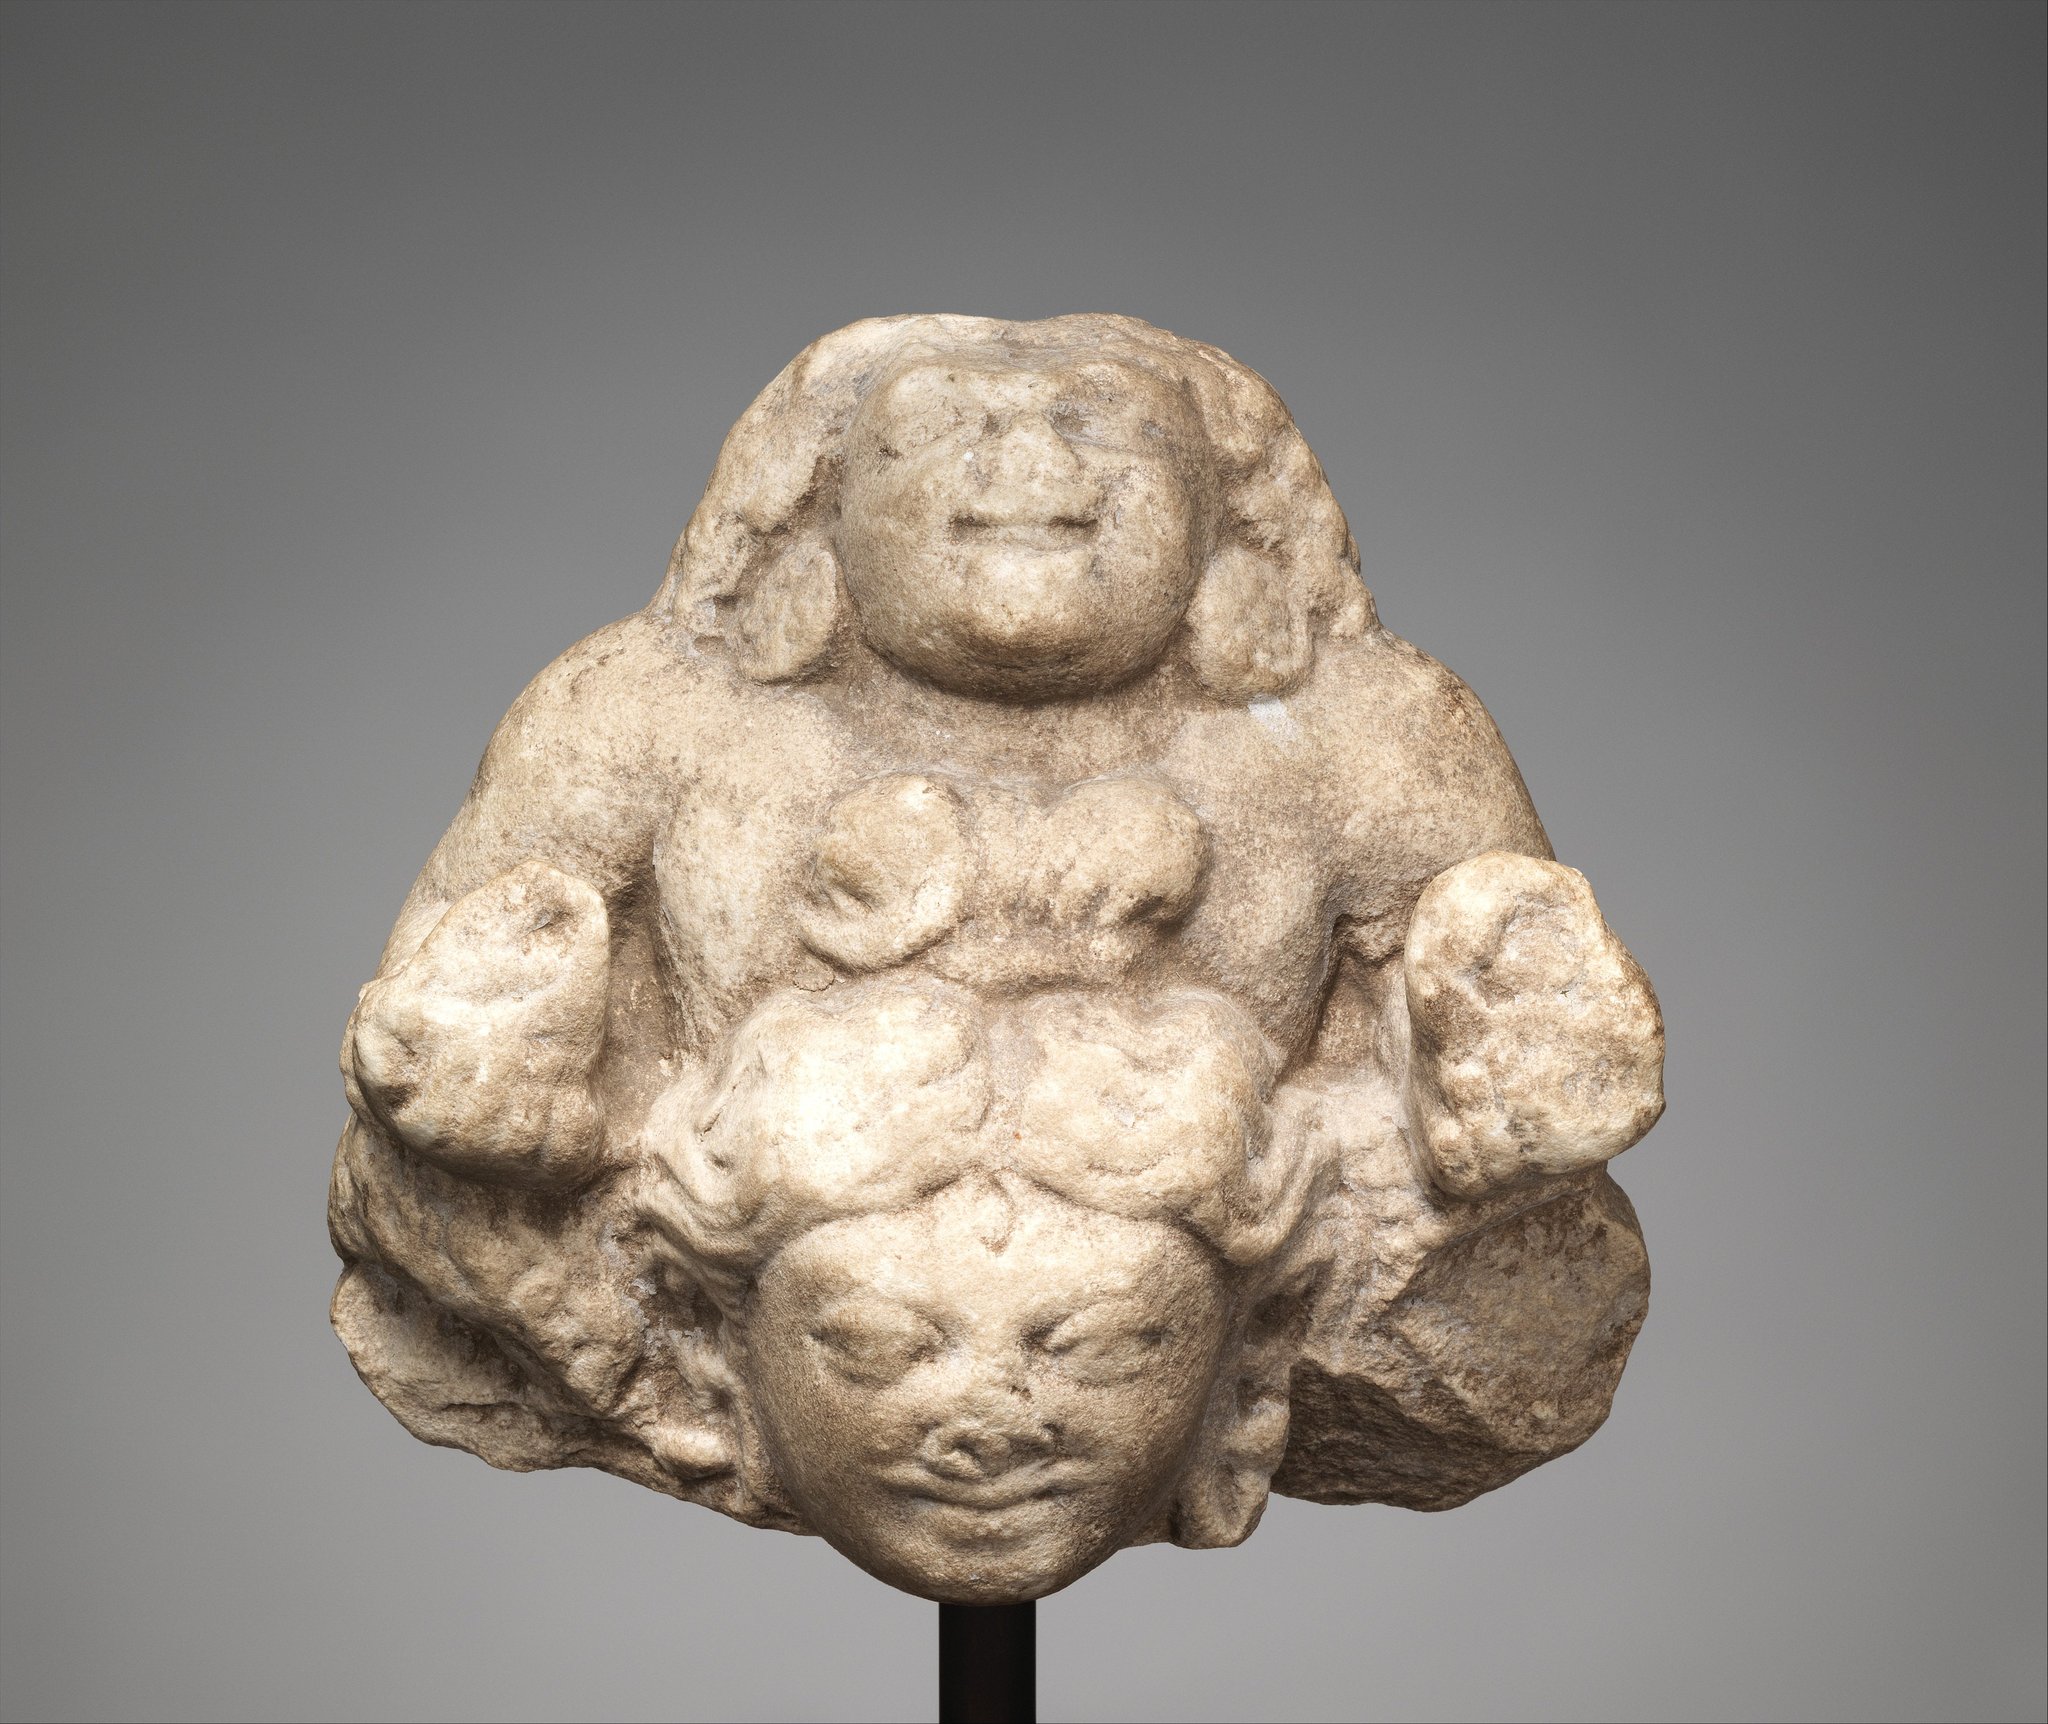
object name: head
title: Head of Addorsed Maheshvara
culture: pakistani, brahmanical post-gupta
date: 501-600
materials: mineral, stone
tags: gandhara,shiva,hinduism